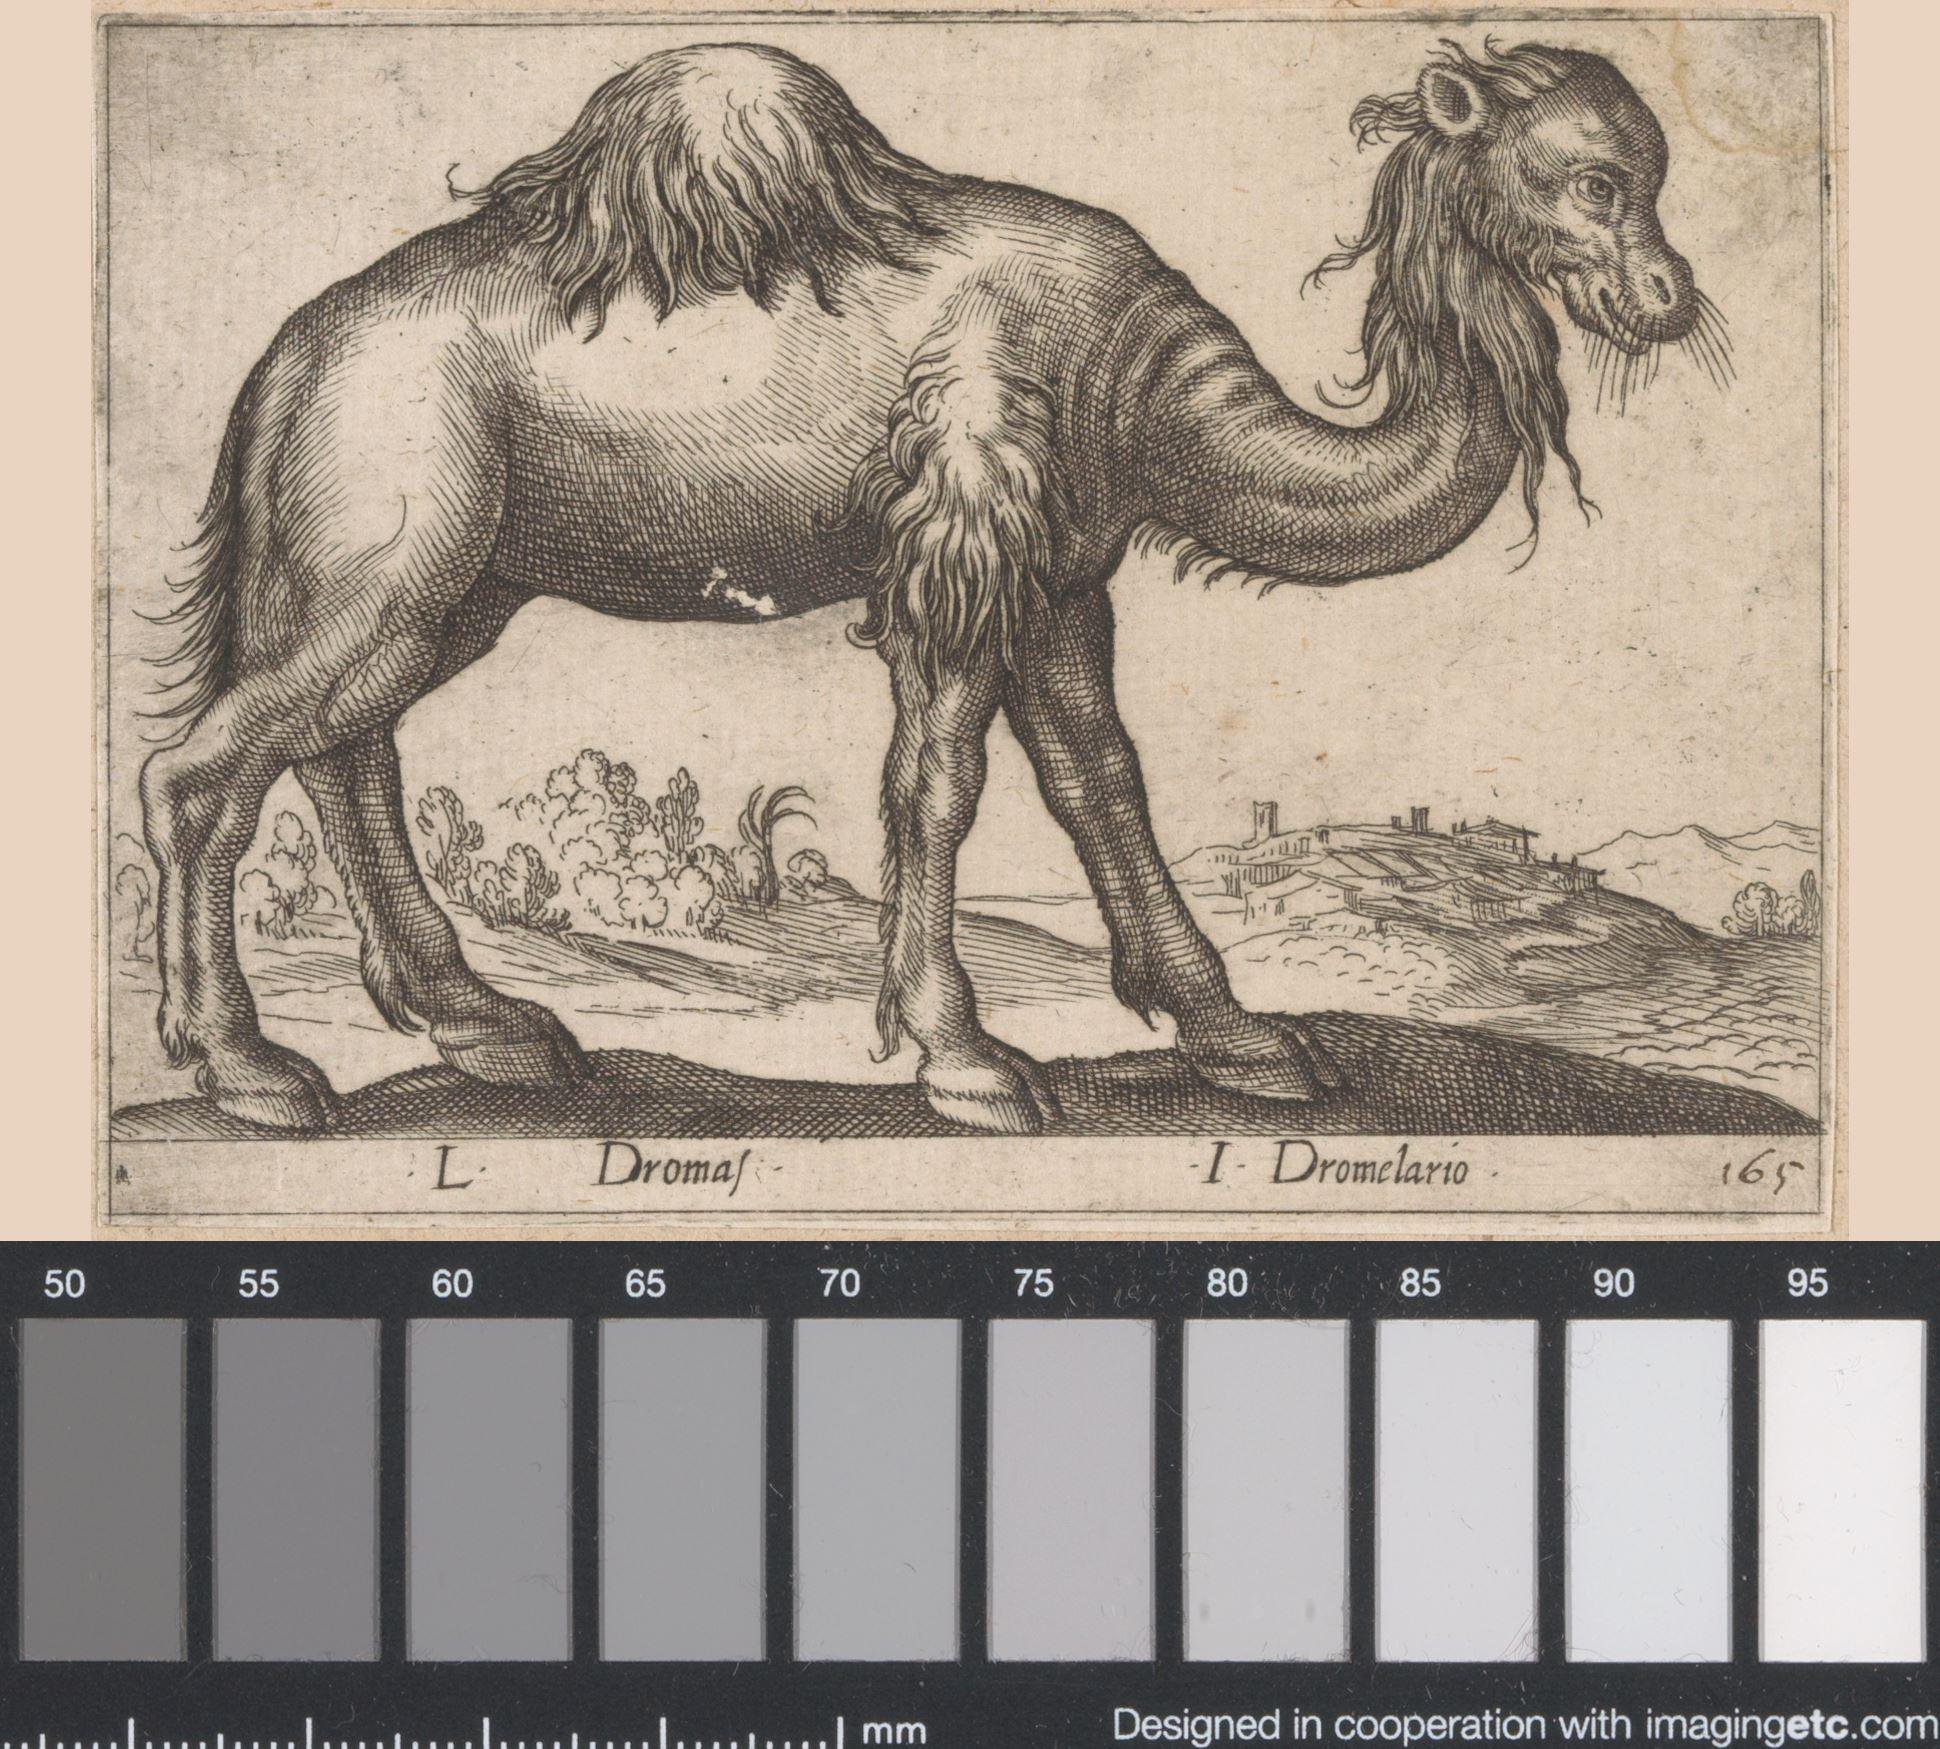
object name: print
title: Dromedaris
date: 1565-1630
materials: paper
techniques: etching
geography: vatican city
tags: hoofed animals: dromedary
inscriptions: number: ‘165’, collector's mark: Lugt 11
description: Deze prent maakt deel uit van een reeks prenten van dieren door Antonio Tempesta. Bekend is dat een tweede staat (met nummering) van deze serie is uitgegeven door Giovanni Giacomo de' Rossi in 1650. Onbekend is wie de eerste staat heeft uitgegeven en wanneer.